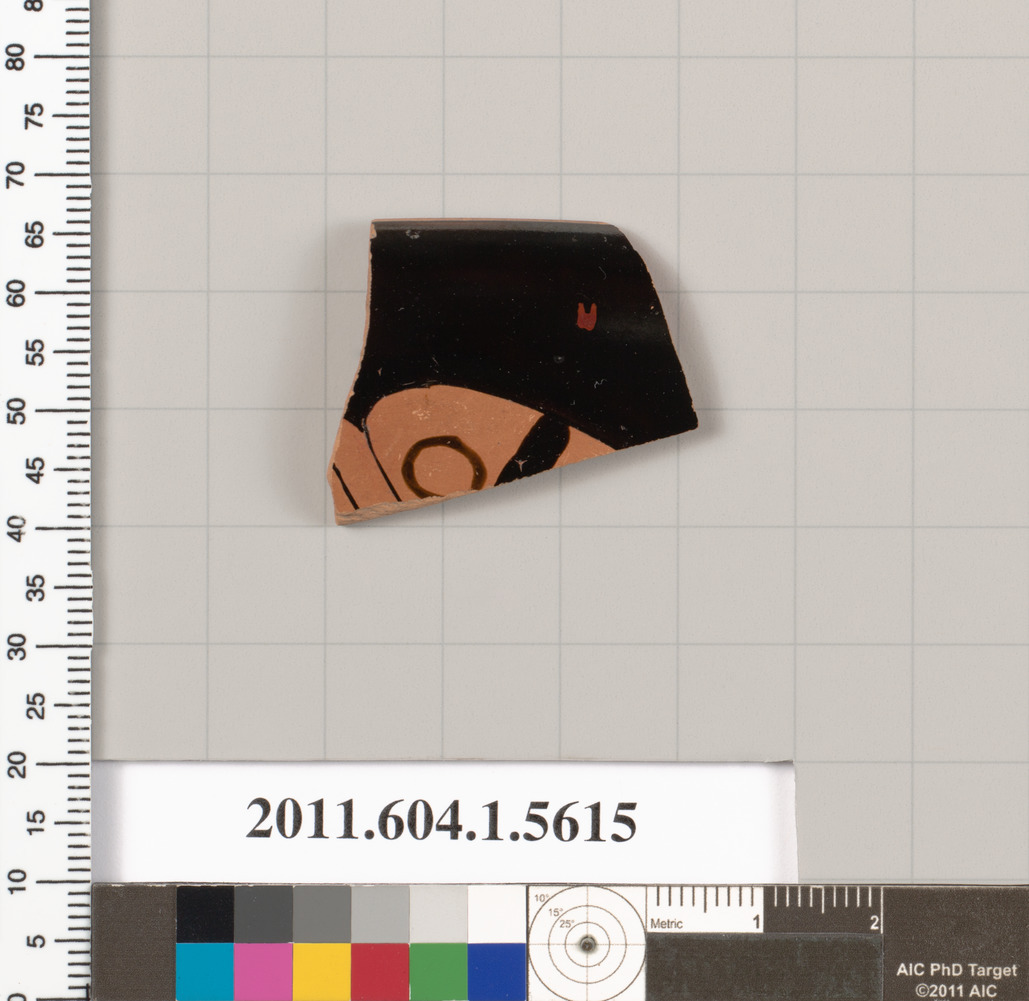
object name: kylix fragment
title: Terracotta rim fragment of a kylix (drinking cup)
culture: greek, attic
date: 510-490 BCE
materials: terracotta